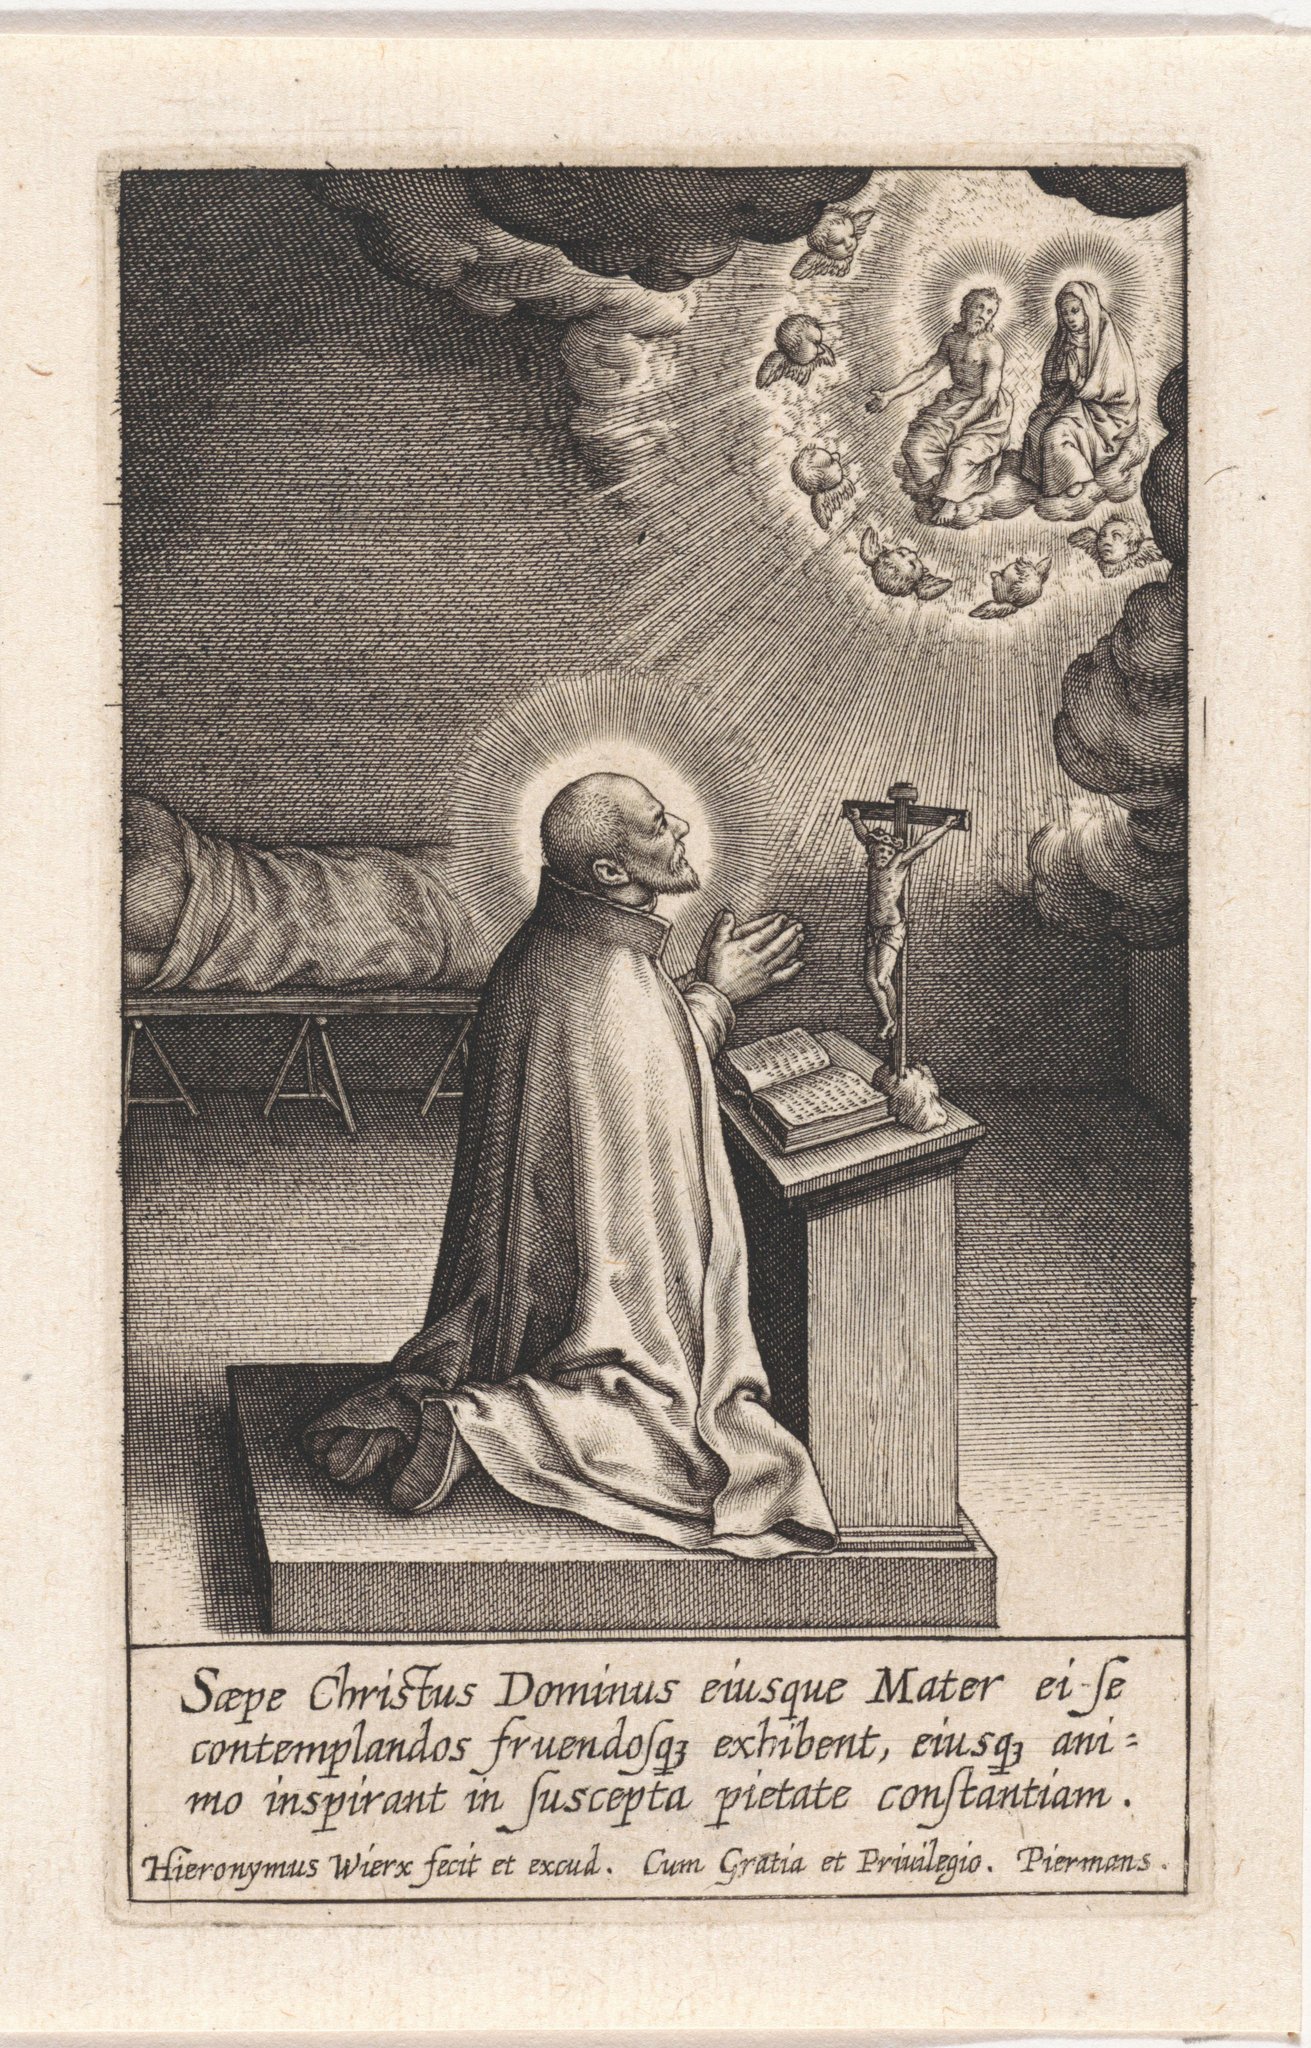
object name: print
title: Ignatius van Loyola heeft een visioen van Christus en Maria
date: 1611-1615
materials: paper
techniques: engraving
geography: antwerp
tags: adult christ with mary, visions of st. ignatius of loyola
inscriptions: collector's mark: Lugt 2228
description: Ignatius van Loyola zit geknield in gebed aan een altaar in een vertrek. Voor hem een visioen van Christus en Maria op de wolken, omringd door cherubijnen. In de marge een drieregelig onderschrift in het Latijn.